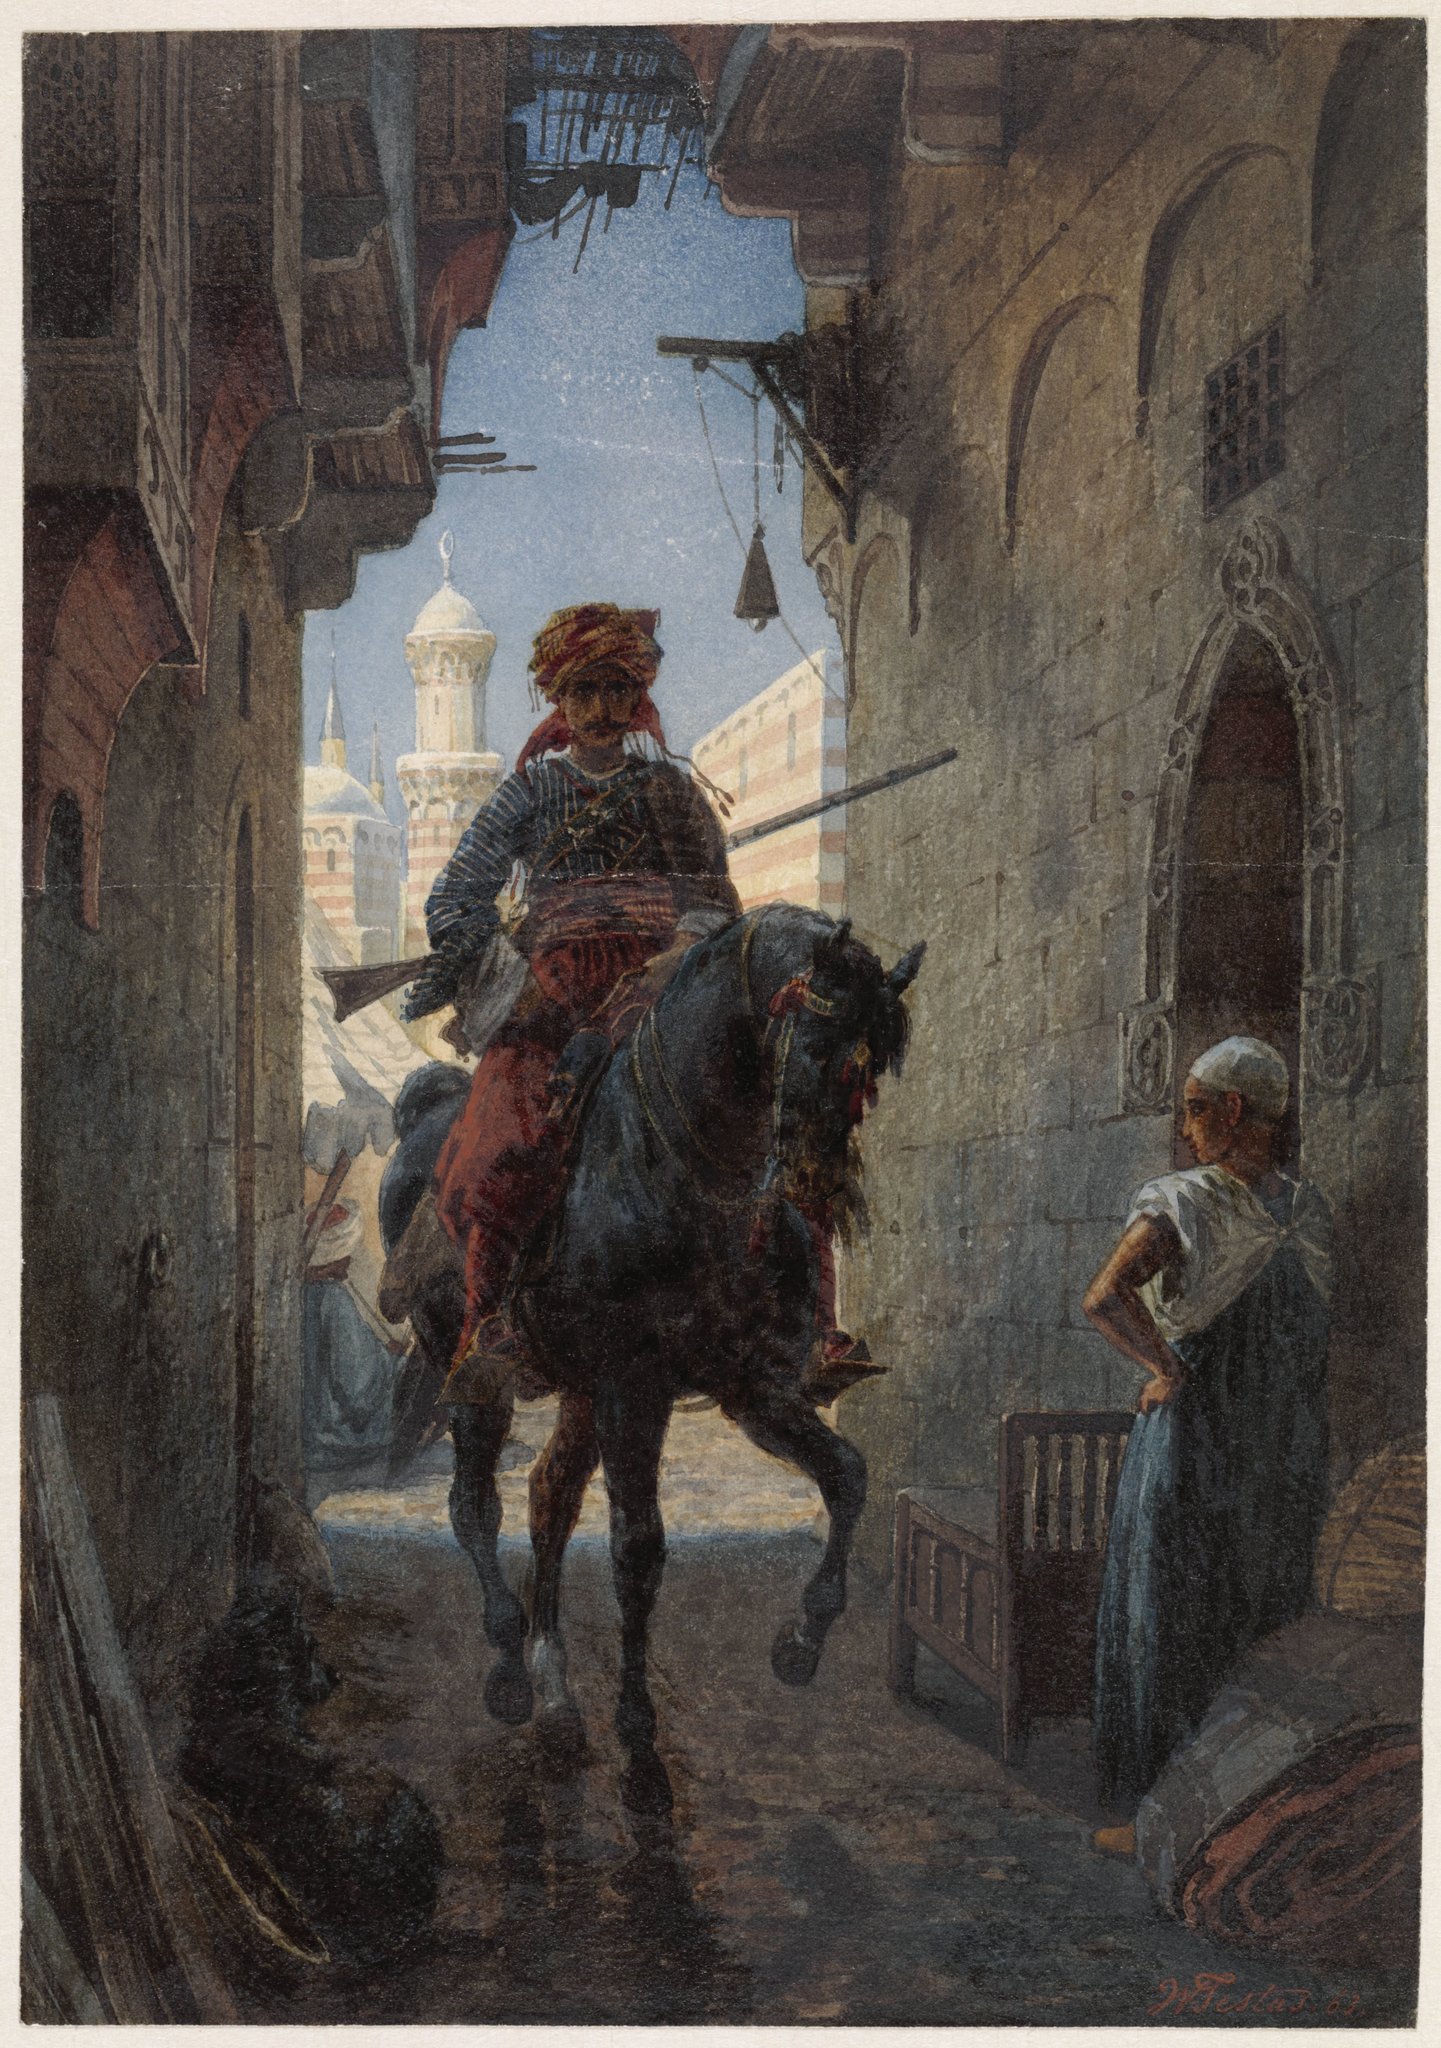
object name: watercolor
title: Turkse ruiter in een stad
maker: willem de famars testas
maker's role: draughtsman, painter, print maker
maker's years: 1834-1896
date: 1863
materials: paper, watercolor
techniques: brush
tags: riding a horse, ass, or mule; rider, horseman, asiatic races and peoples: turks